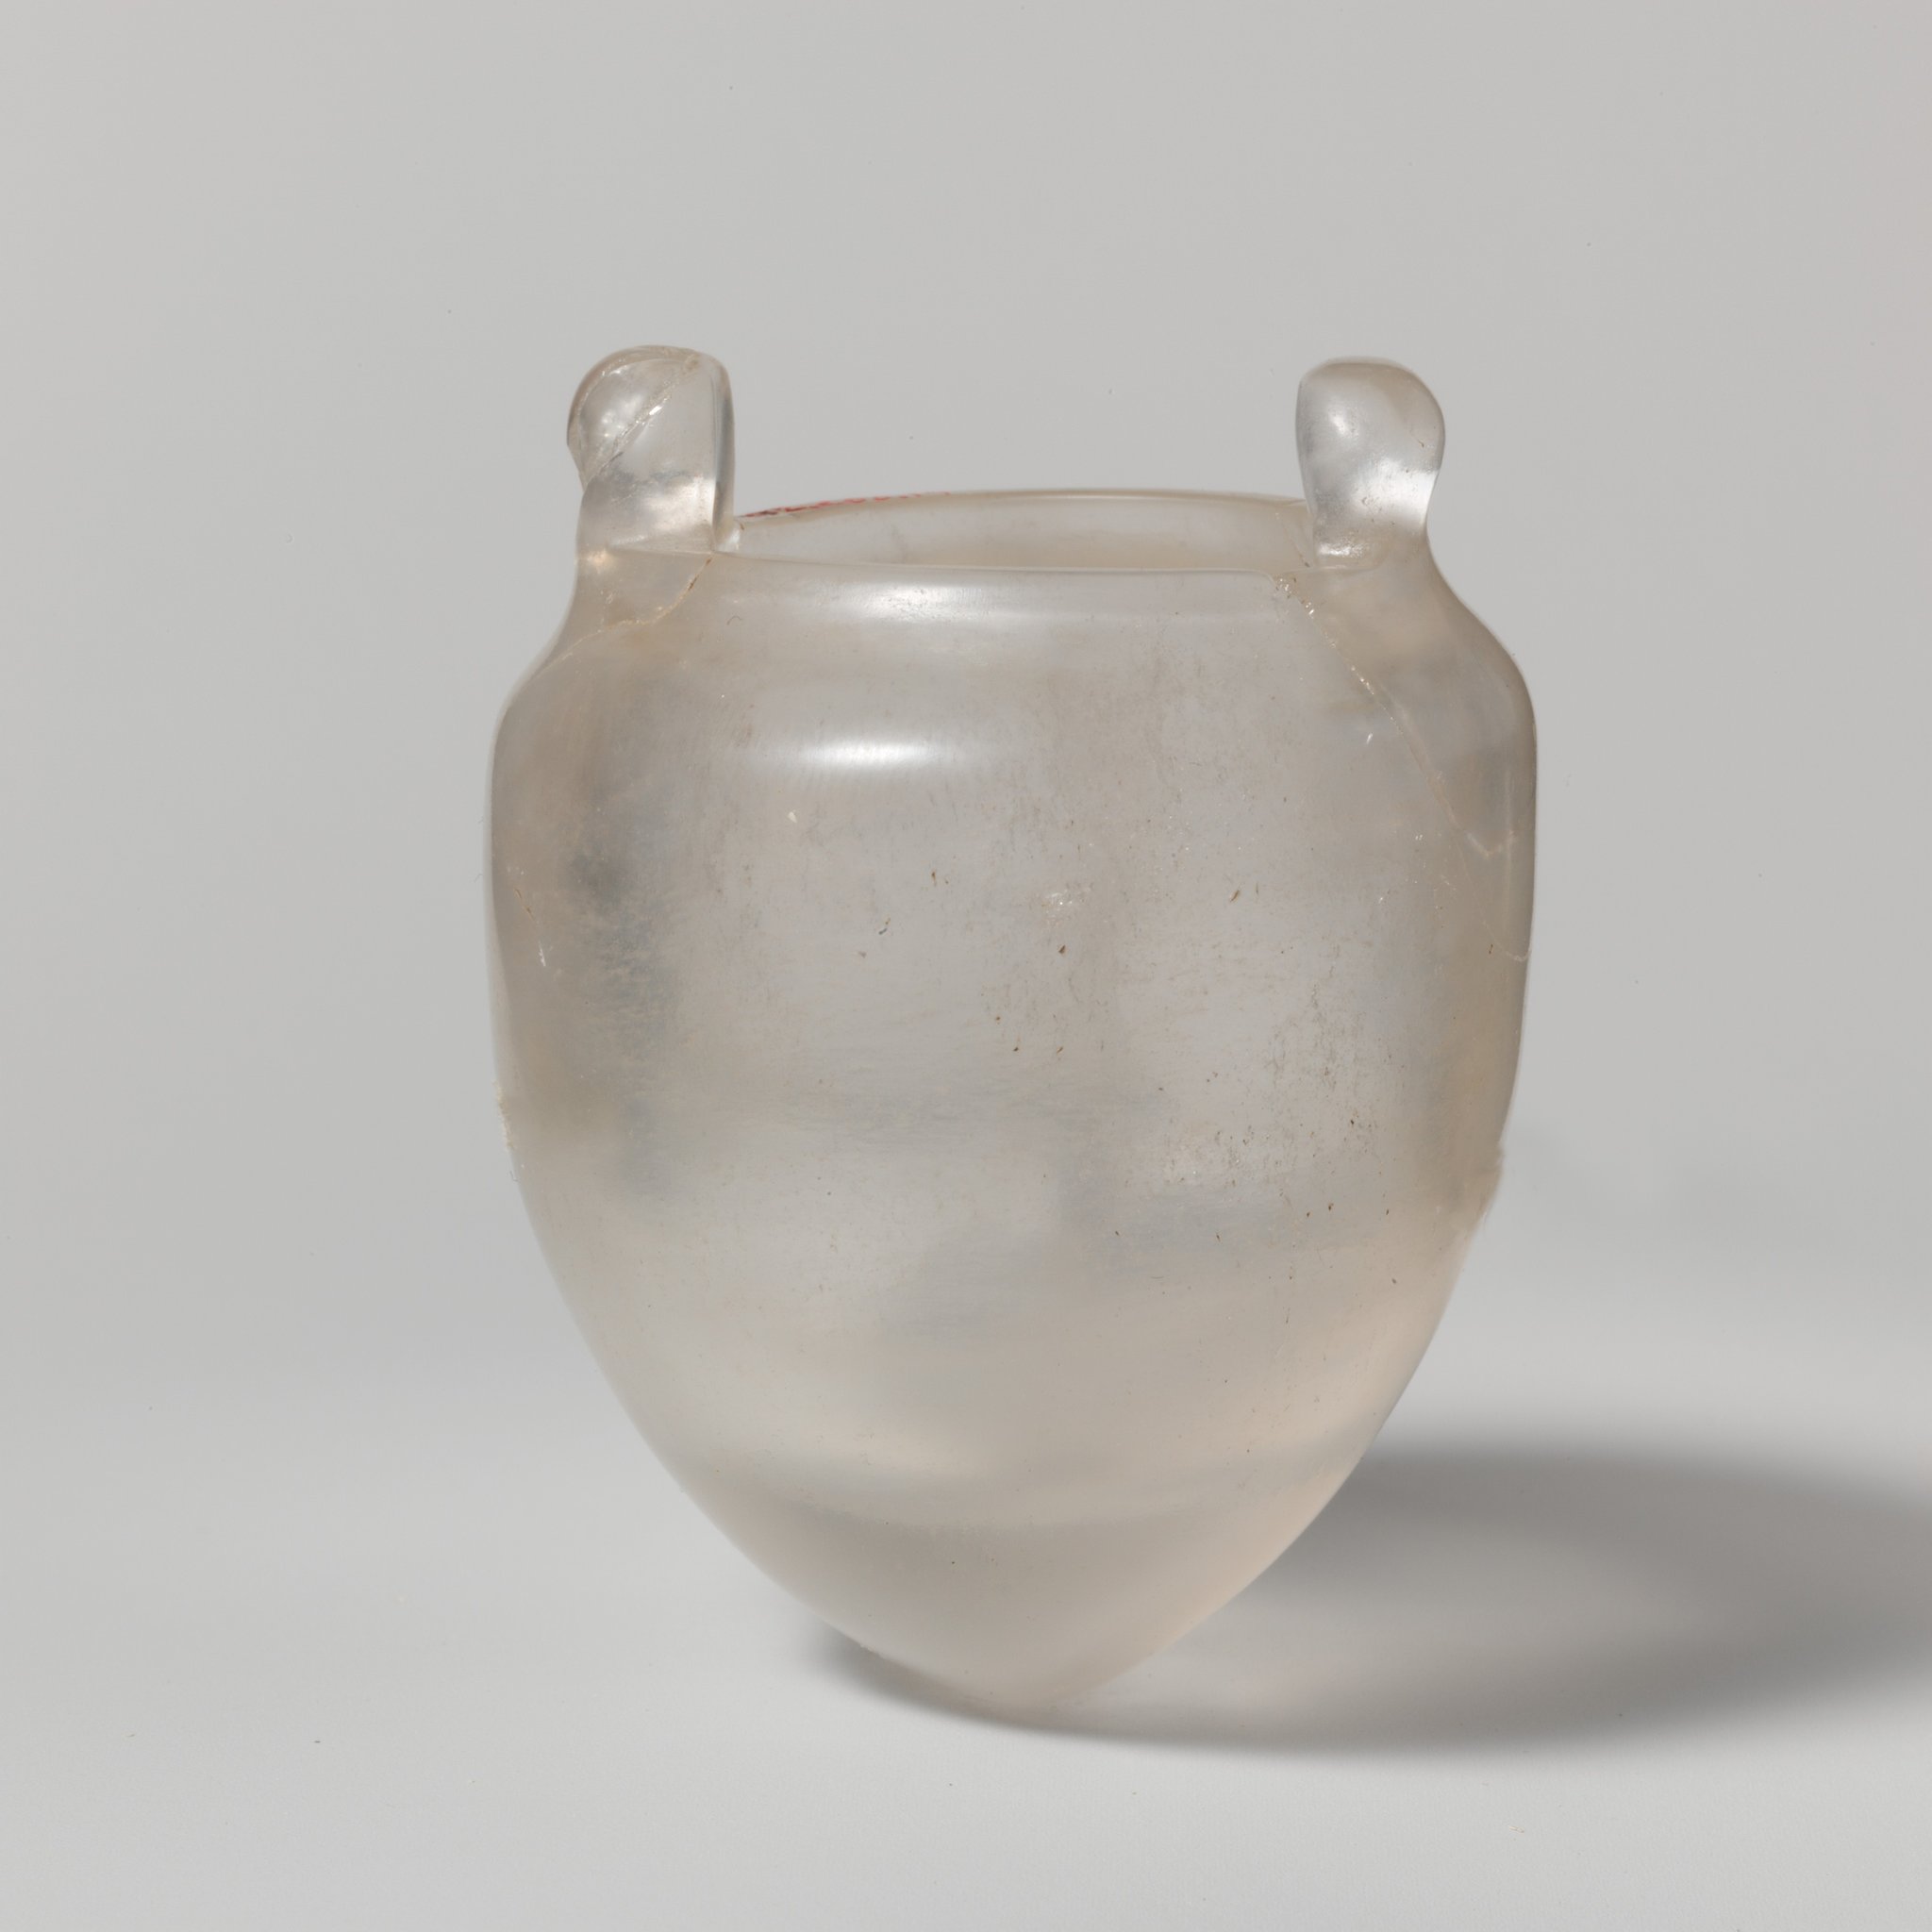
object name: vase, ovoid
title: Rock-crystal ovoid vessel with wide mouth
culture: greek, eastern mediterranean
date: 400-201 BCE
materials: quartz